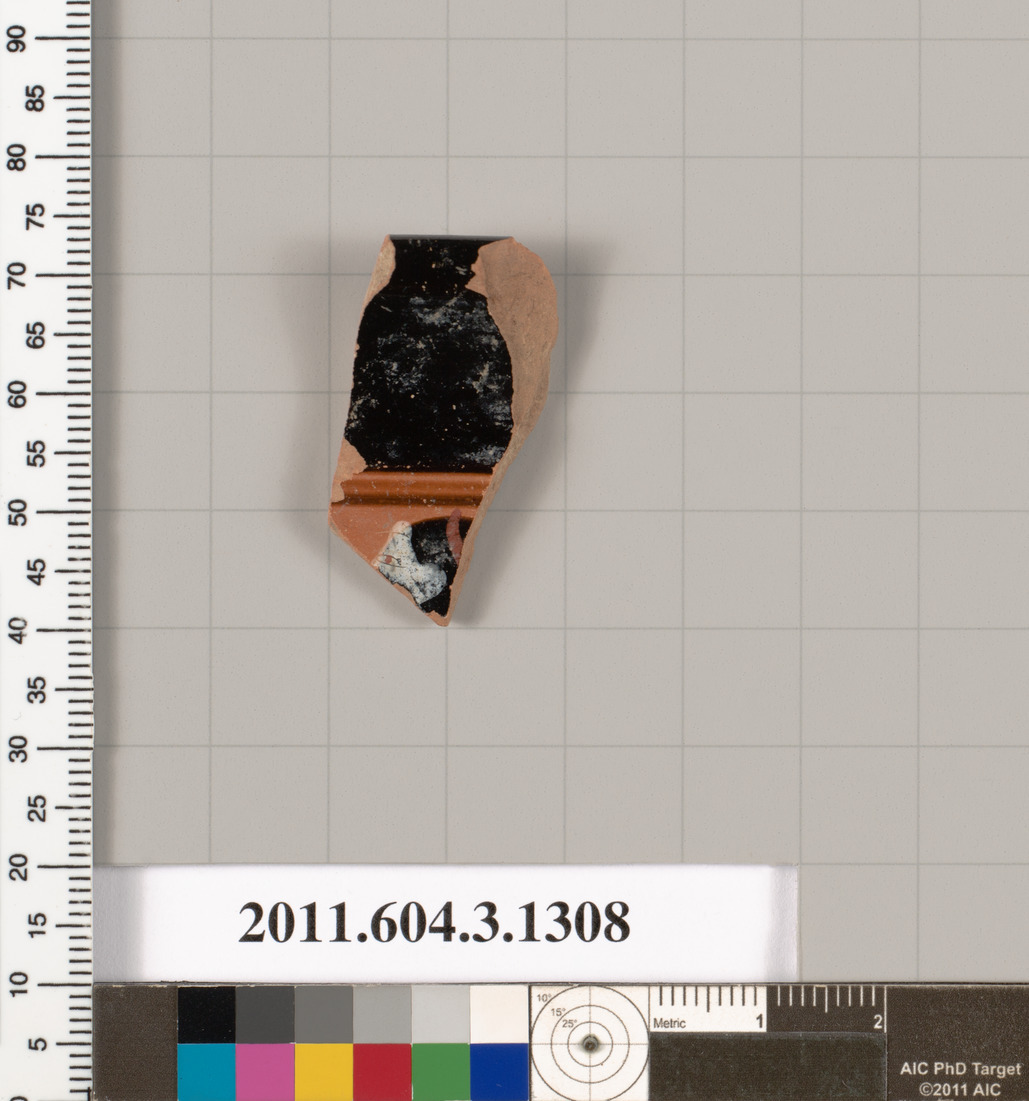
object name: skyphos fragment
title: Terracotta rim fragment of a skyphos (deep drinking cup)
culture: greek, attic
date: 500-468 BCE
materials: terracotta